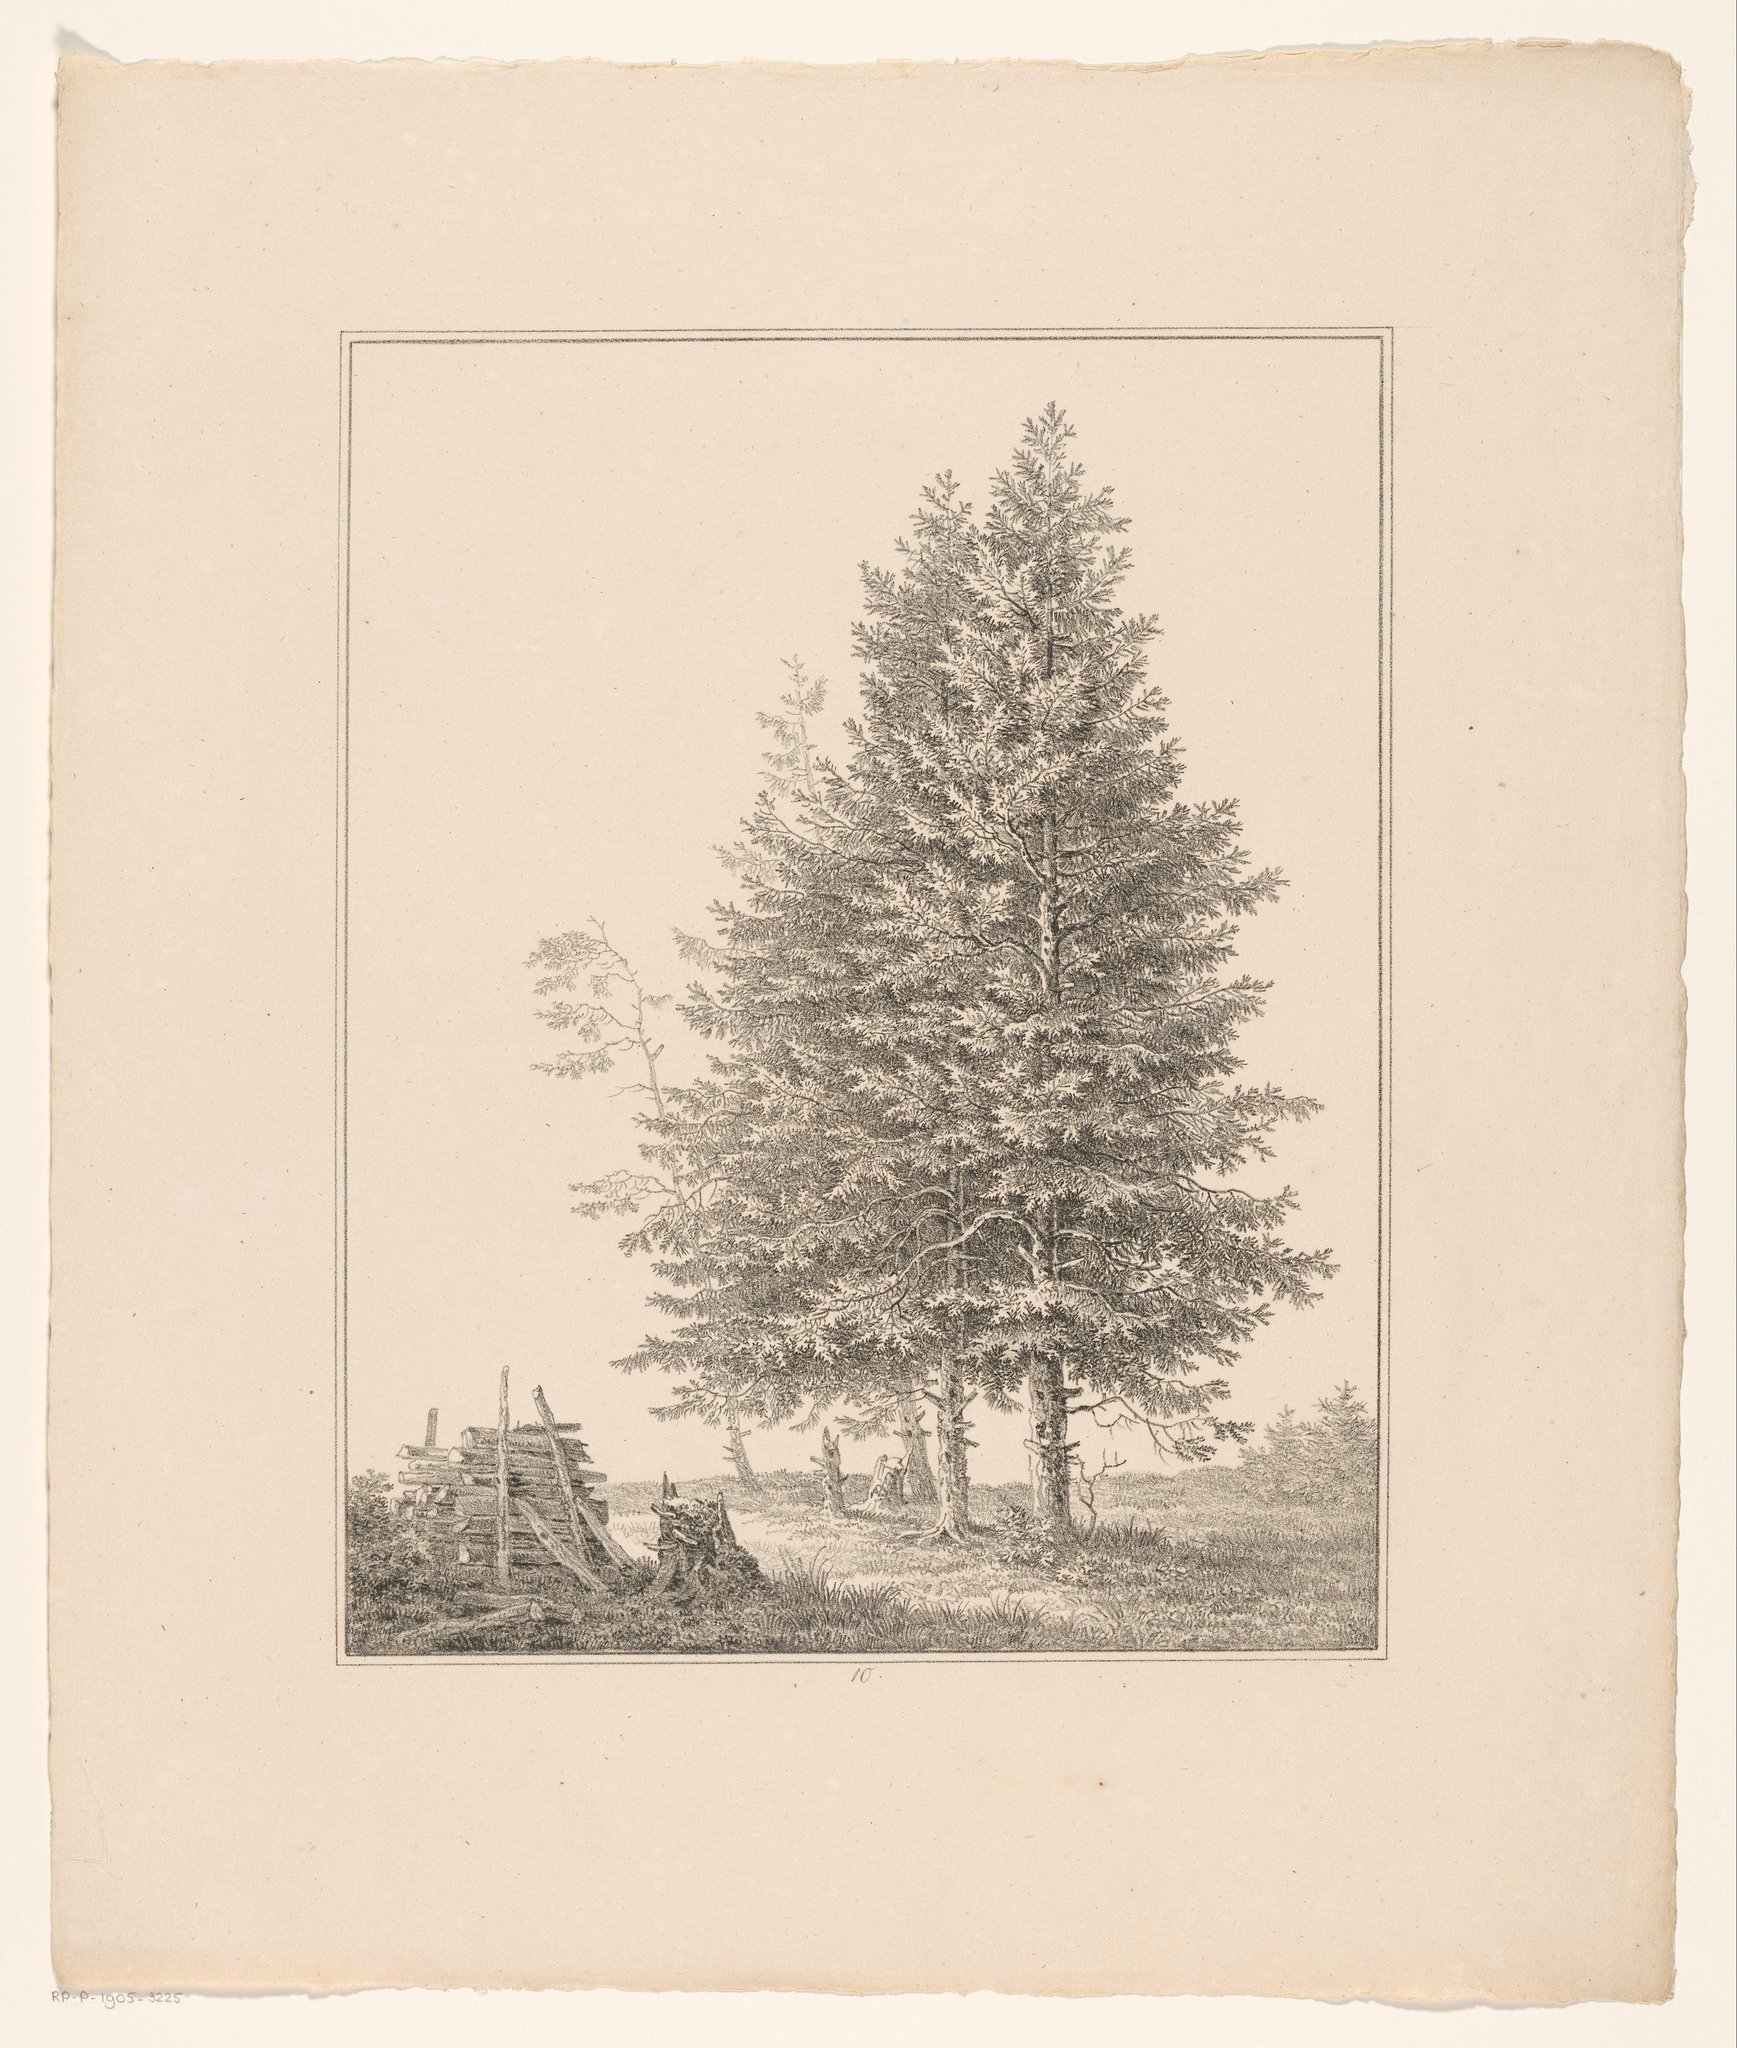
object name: print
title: Boomstudien / 1e Bundel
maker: adrianus van der koogh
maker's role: draughtsman, print maker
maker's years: 1796-1831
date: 1826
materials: paper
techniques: lithograph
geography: dordrecht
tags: trees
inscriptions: collector's mark: Lugt 2228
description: Naaldbomen in landschap met links een hek.